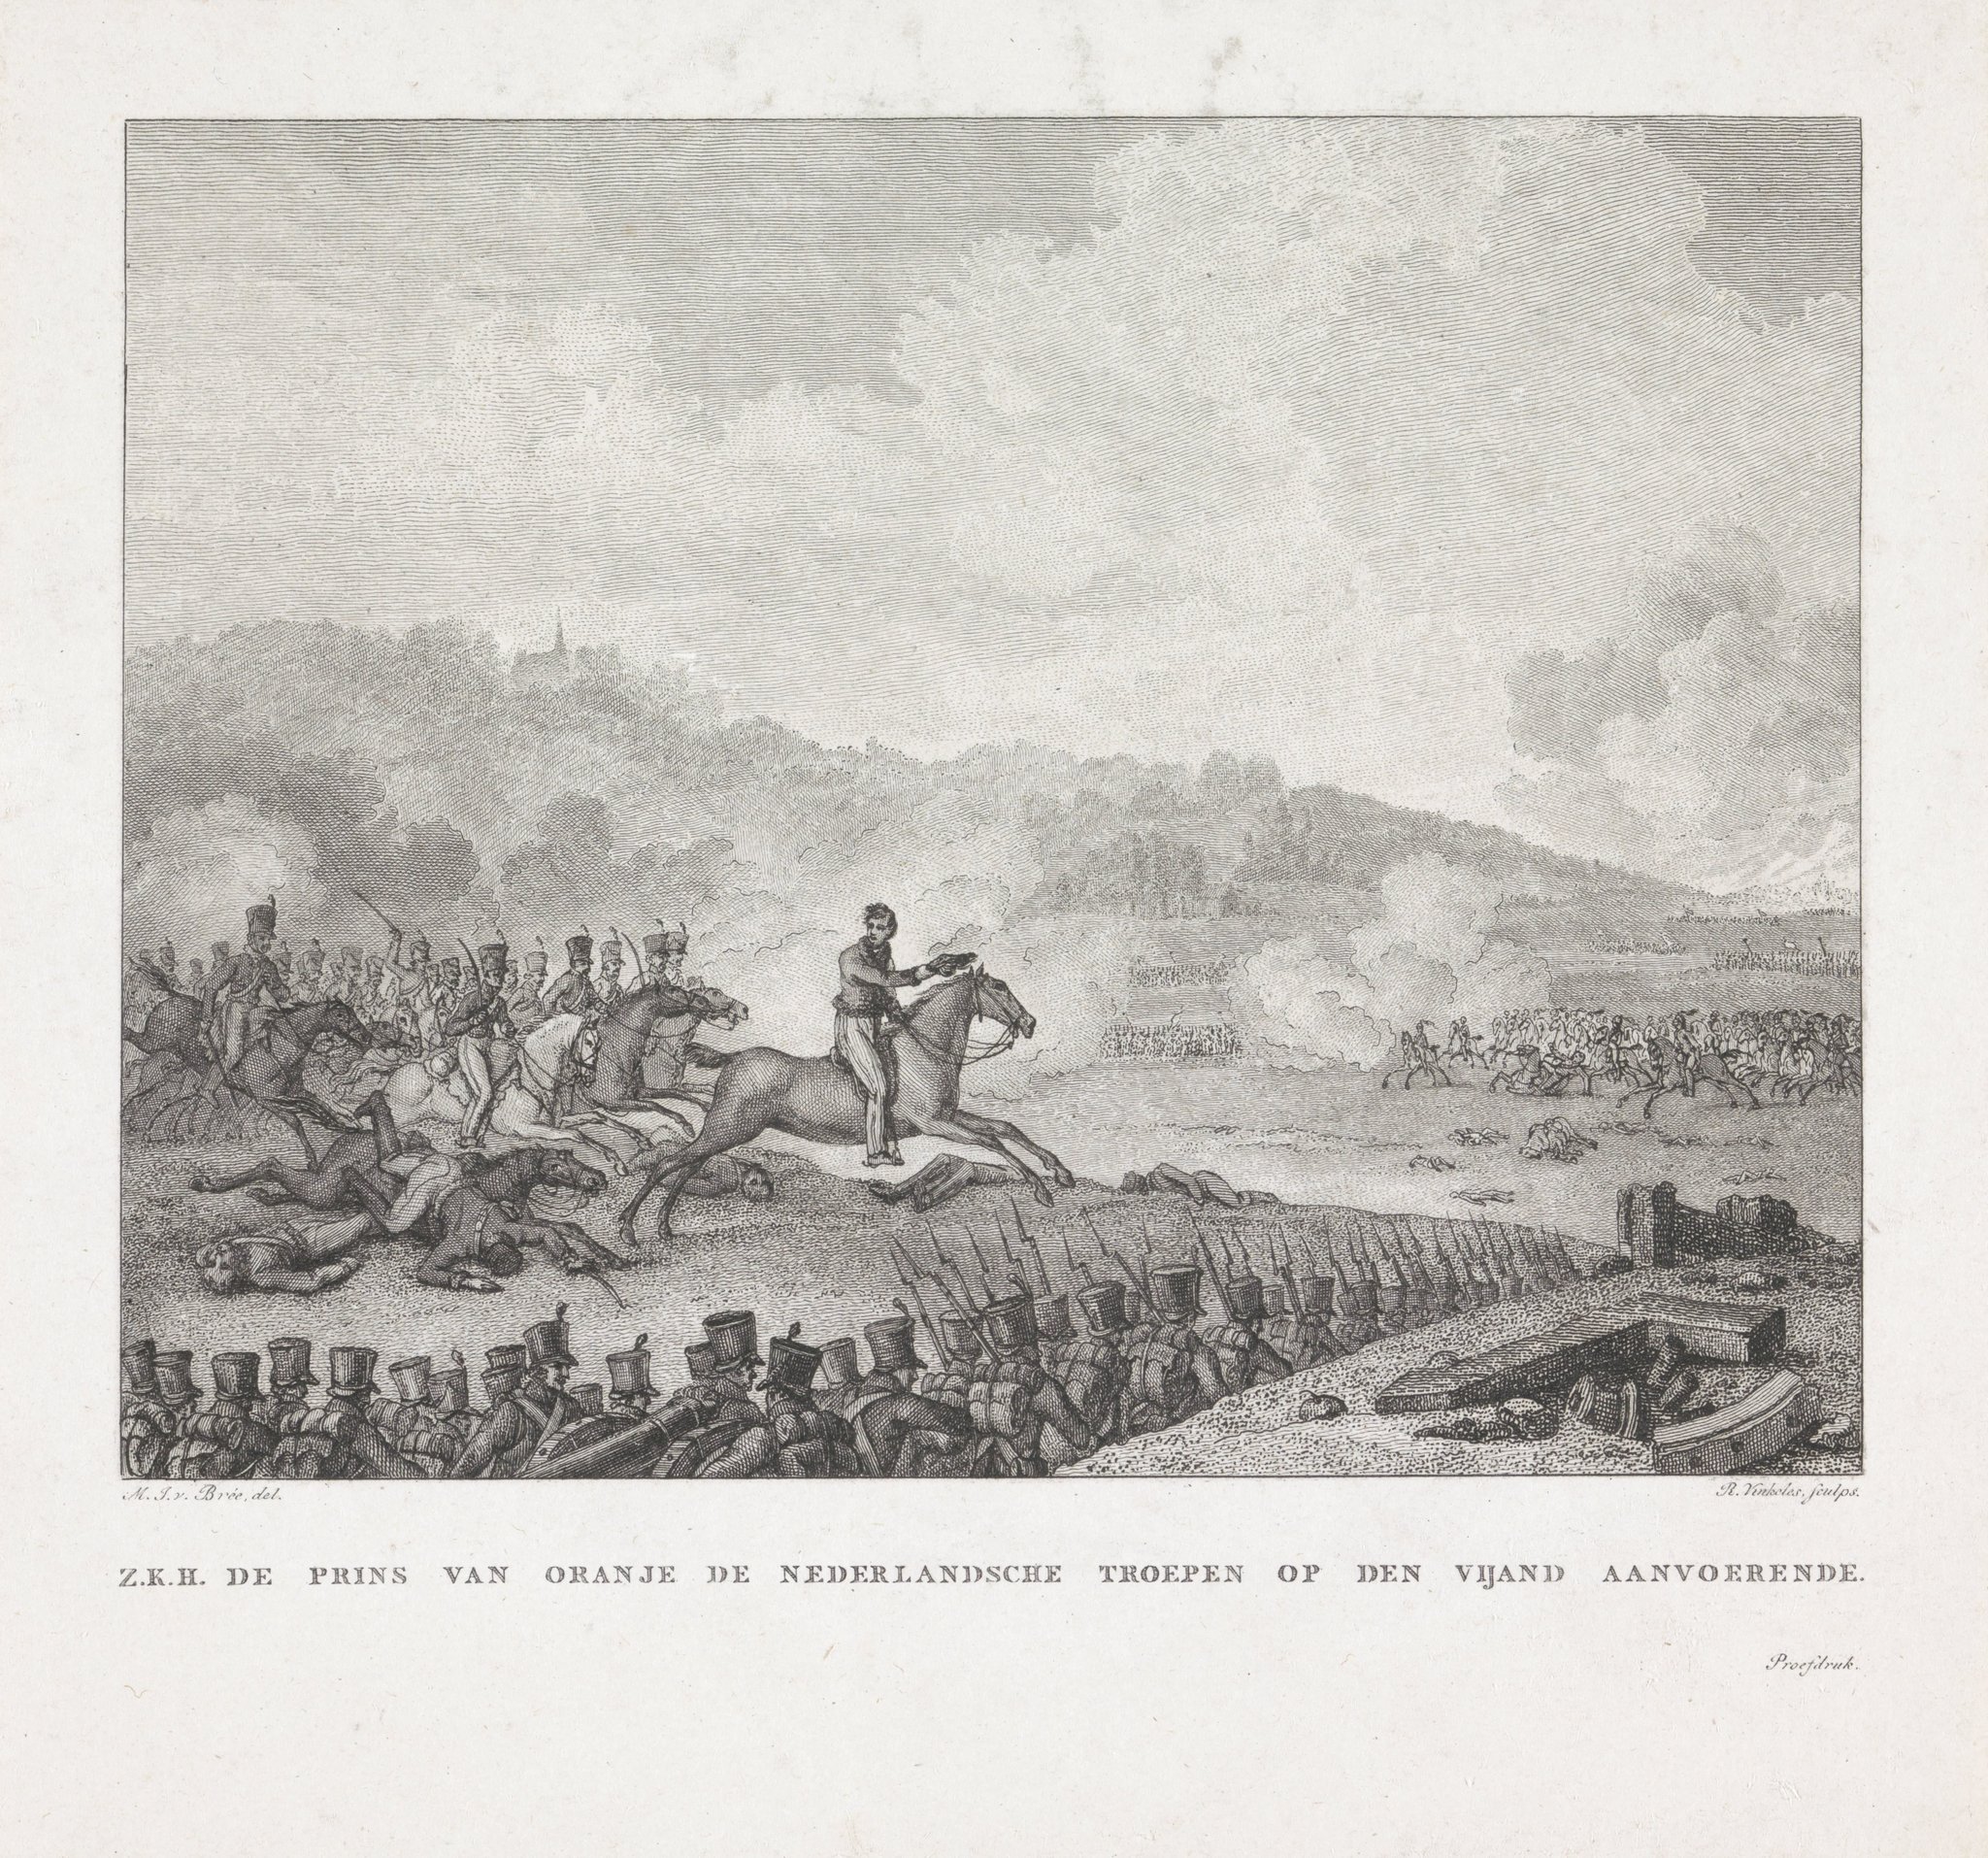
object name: print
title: Prins van Oranje leidt de Nederlandse troepen bij Quatre-Bras, 1815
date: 1815-1816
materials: paper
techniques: engraving, etching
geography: netherlands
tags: the hague, william ii of the netherlands, battle (+ land forces)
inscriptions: collector's mark: Lugt 2228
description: Willem Frederik George, prins van Oranje, leidt de aanval van de Nederlandse troepen tegen de Fransen in de slag bij Quatre-Bras, 16 juni 1815. Onderdeel van een groep illustraties van gebeurtenissen rond en tijdens de veldslagen bij Quatre-Bras en Waterloo, 16-18 juni 1815.